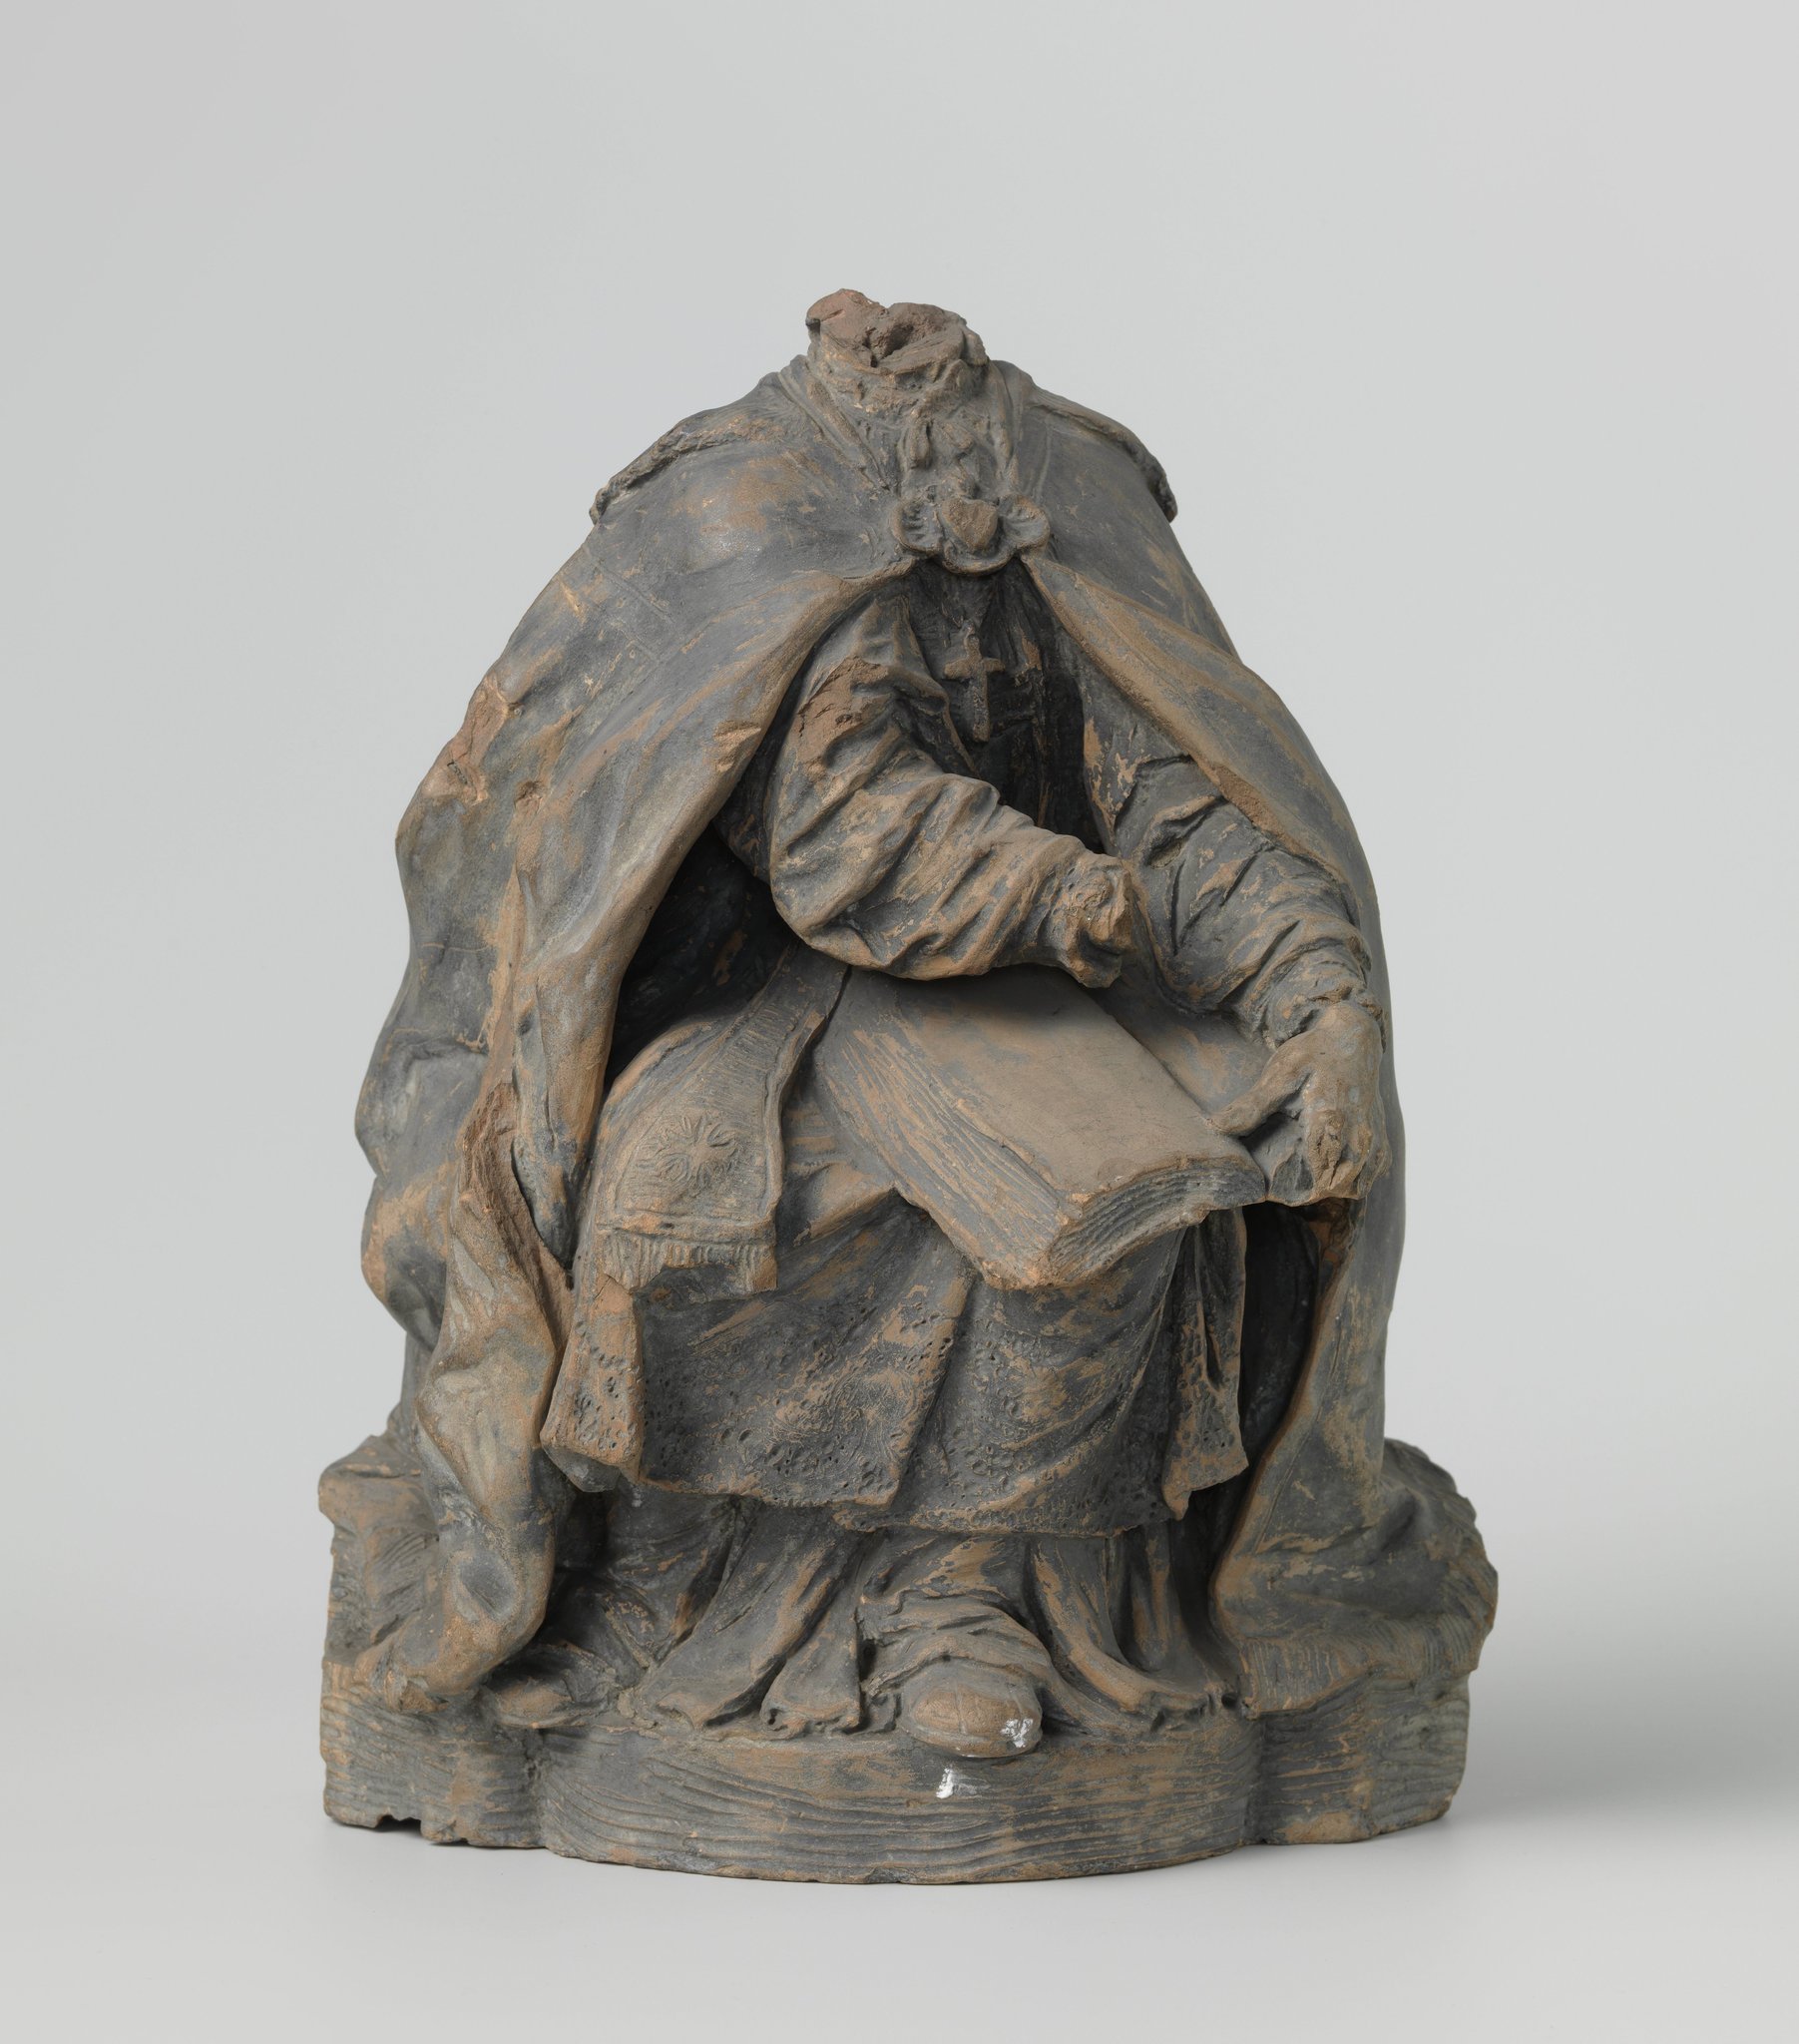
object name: sculpture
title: Zittende bisschop met opengeslagen boek op de knieen. Zijn hoofd ontbreekt.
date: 1700-1800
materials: terracotta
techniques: modeling